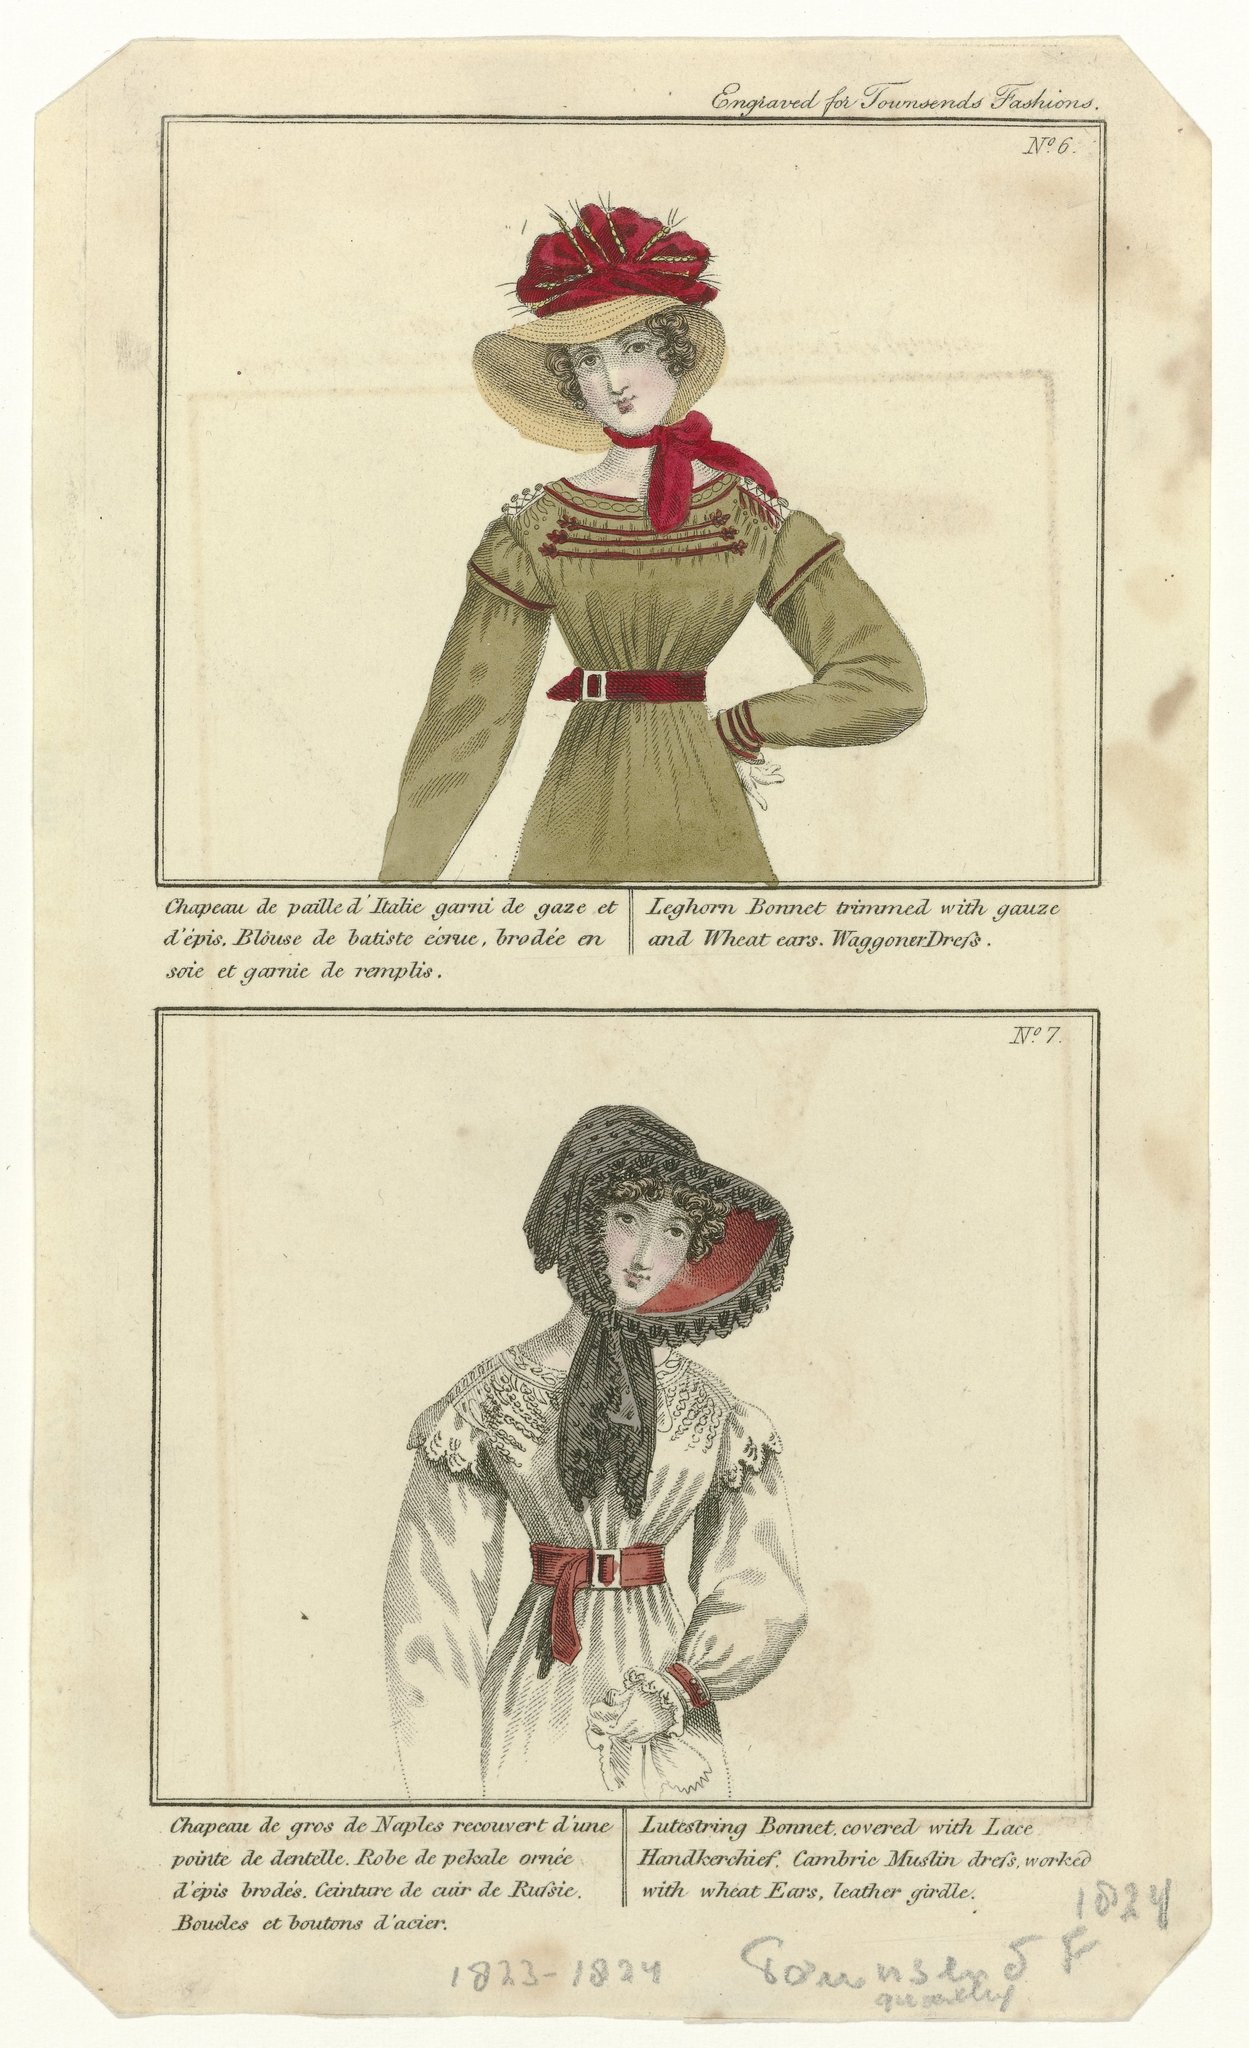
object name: fashion print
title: Townsend's Monthly Selection of Parisian Costumes, 1824, No. 6 en No. 7 : Chapeau de paill (...)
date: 1824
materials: paper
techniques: etching, hand coloring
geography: london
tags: handkerchief (+ women's clothes), ornamental parts of clothing (+ women's clothes), embroidery (ornamentation) (+ women's clothes), clothing for the upper part of the body: blouse (+ women's clothes), lace (+ women's clothes), buckle (+ women's clothes), button (+ other materials used for clothes), belt, girdle, waistband (+ leather used for clothes), fashion plates, head-gear: hat (+ women's clothes), dress, gown (+ women's clothes), belt, girdle, waistband (+ women's clothes)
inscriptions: caption: ‘No. 7 : Chapeau de gros de Naples recouvert d'une pointe de dentelle. Robe de perkale ornée d'épis brodés. Ceinture de cuir de Russie. Bouvles et boutons d'acier. / Lutestring Bonnet, covered with Lace Handkerchief. Cambric Muslin dress, worked with wheat ears, leather girdle.’, caption: ‘No. 6 : Chapeau de paille d'Italie garni de gaze et d'épis. Blouse de batiste écrue, brodée en soie et garnie de remplis. / Leghorn Bonnet trimmed with gauze and Wheat ears. Waggoner Dress.’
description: Twee vrouwen, ten halven lijve, genummerd 6 en 7, boven elkaar op één plaat. Onderschrift in het Frans en Engels. No. 6 : Hoed of 'Leghorn Bonnet' van 'paille d'Italie', versierd met tule en aren. 'Blouse' of 'Waggoner Dress' van batist, geborduurd met zijde en versierd met 'remplis'. Ceintuur. No. 7 : Luifelhoed of 'Lutestring Bonnet' van 'gros de Naples', overtrokken met kant. Japon van katoenbatist (percale) versierd met geborduurde aren. Ceintuur van leer. Gespen en knopen van staal. Prent uit het modetijdschrift Townsend's Monthly Selection of Parisian Costumes (London 1823-1888).